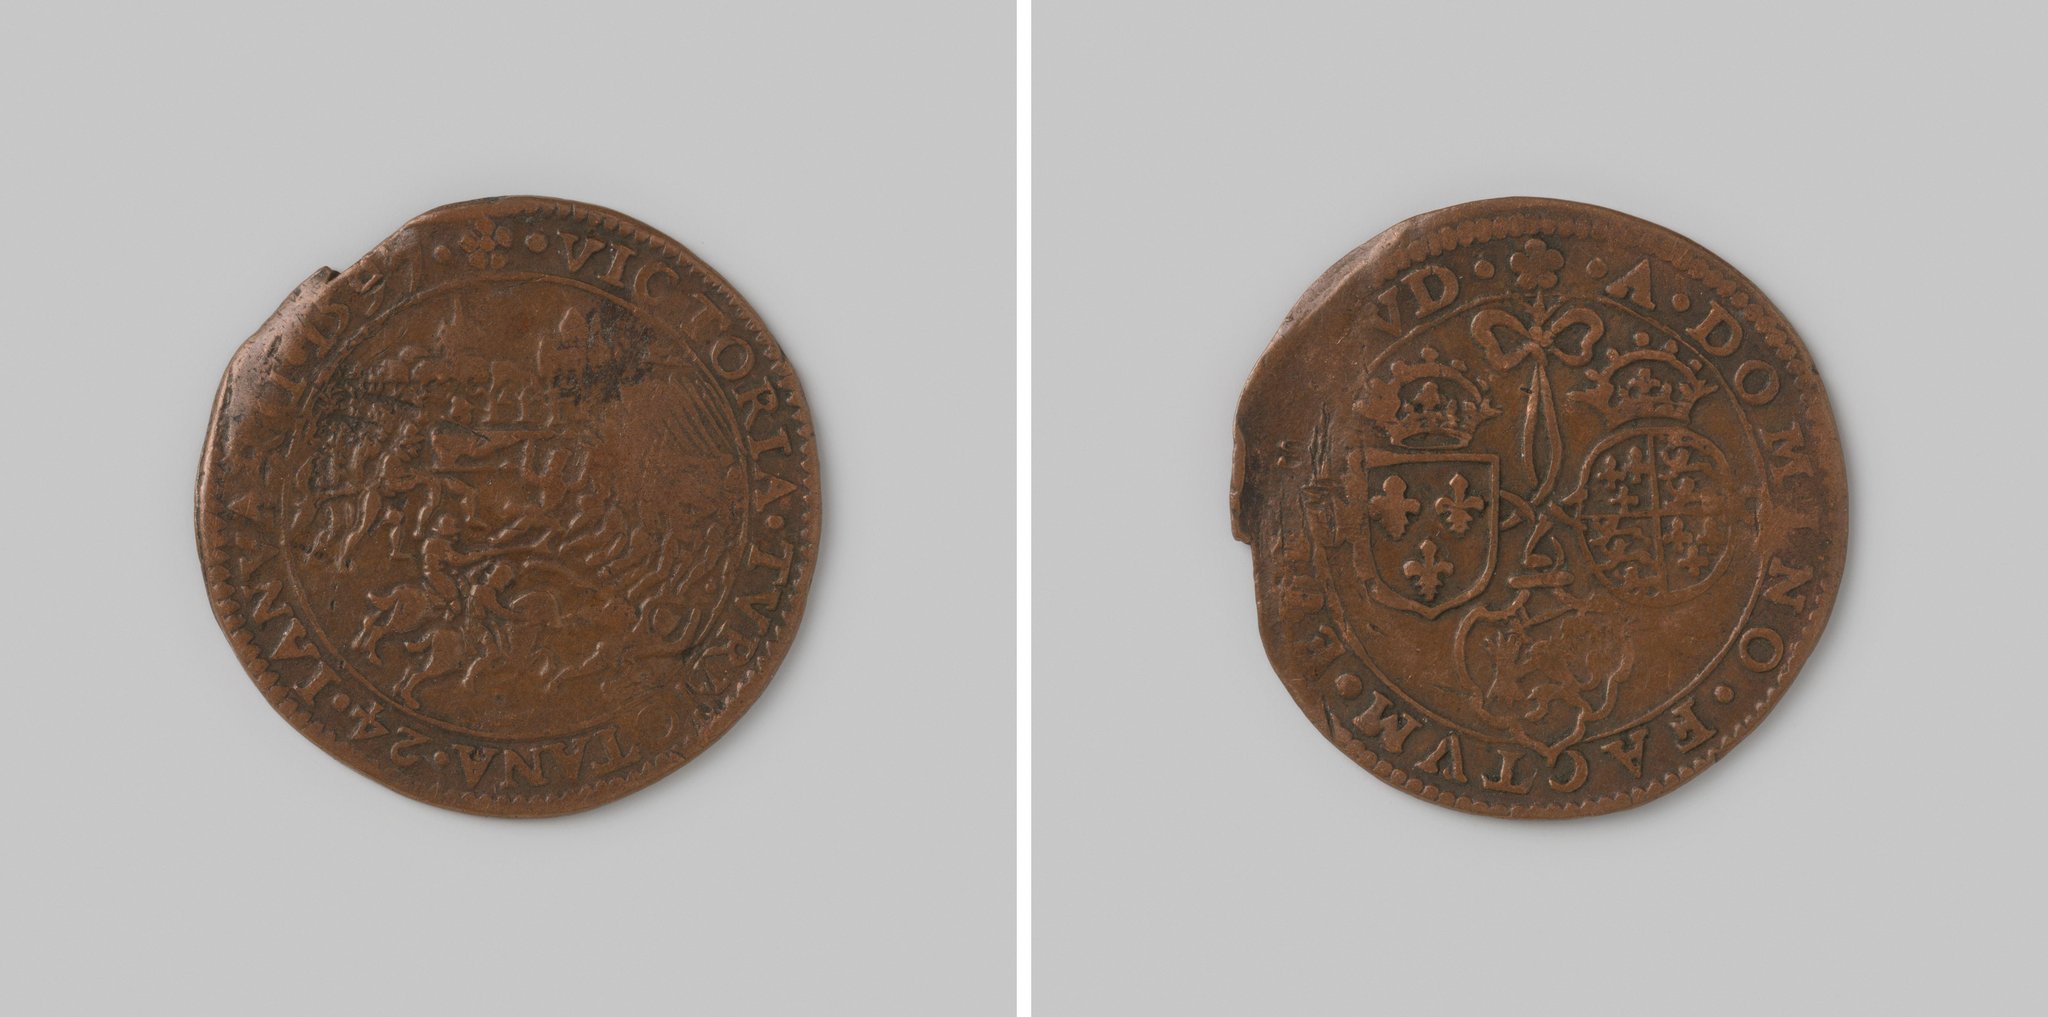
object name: jeton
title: Rekenpenning uit Dordrecht op de overwinning in de Slag bij bij Turnhout 1597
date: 1597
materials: copper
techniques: striking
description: Koperen penning, op de voorzijde het verdrijven van het vijandelijke leger, met omschrift, op de keerzijde aan één lint de wapenschilden van Frankrijk, Groot Brittannië en Nederland, met omschrift.